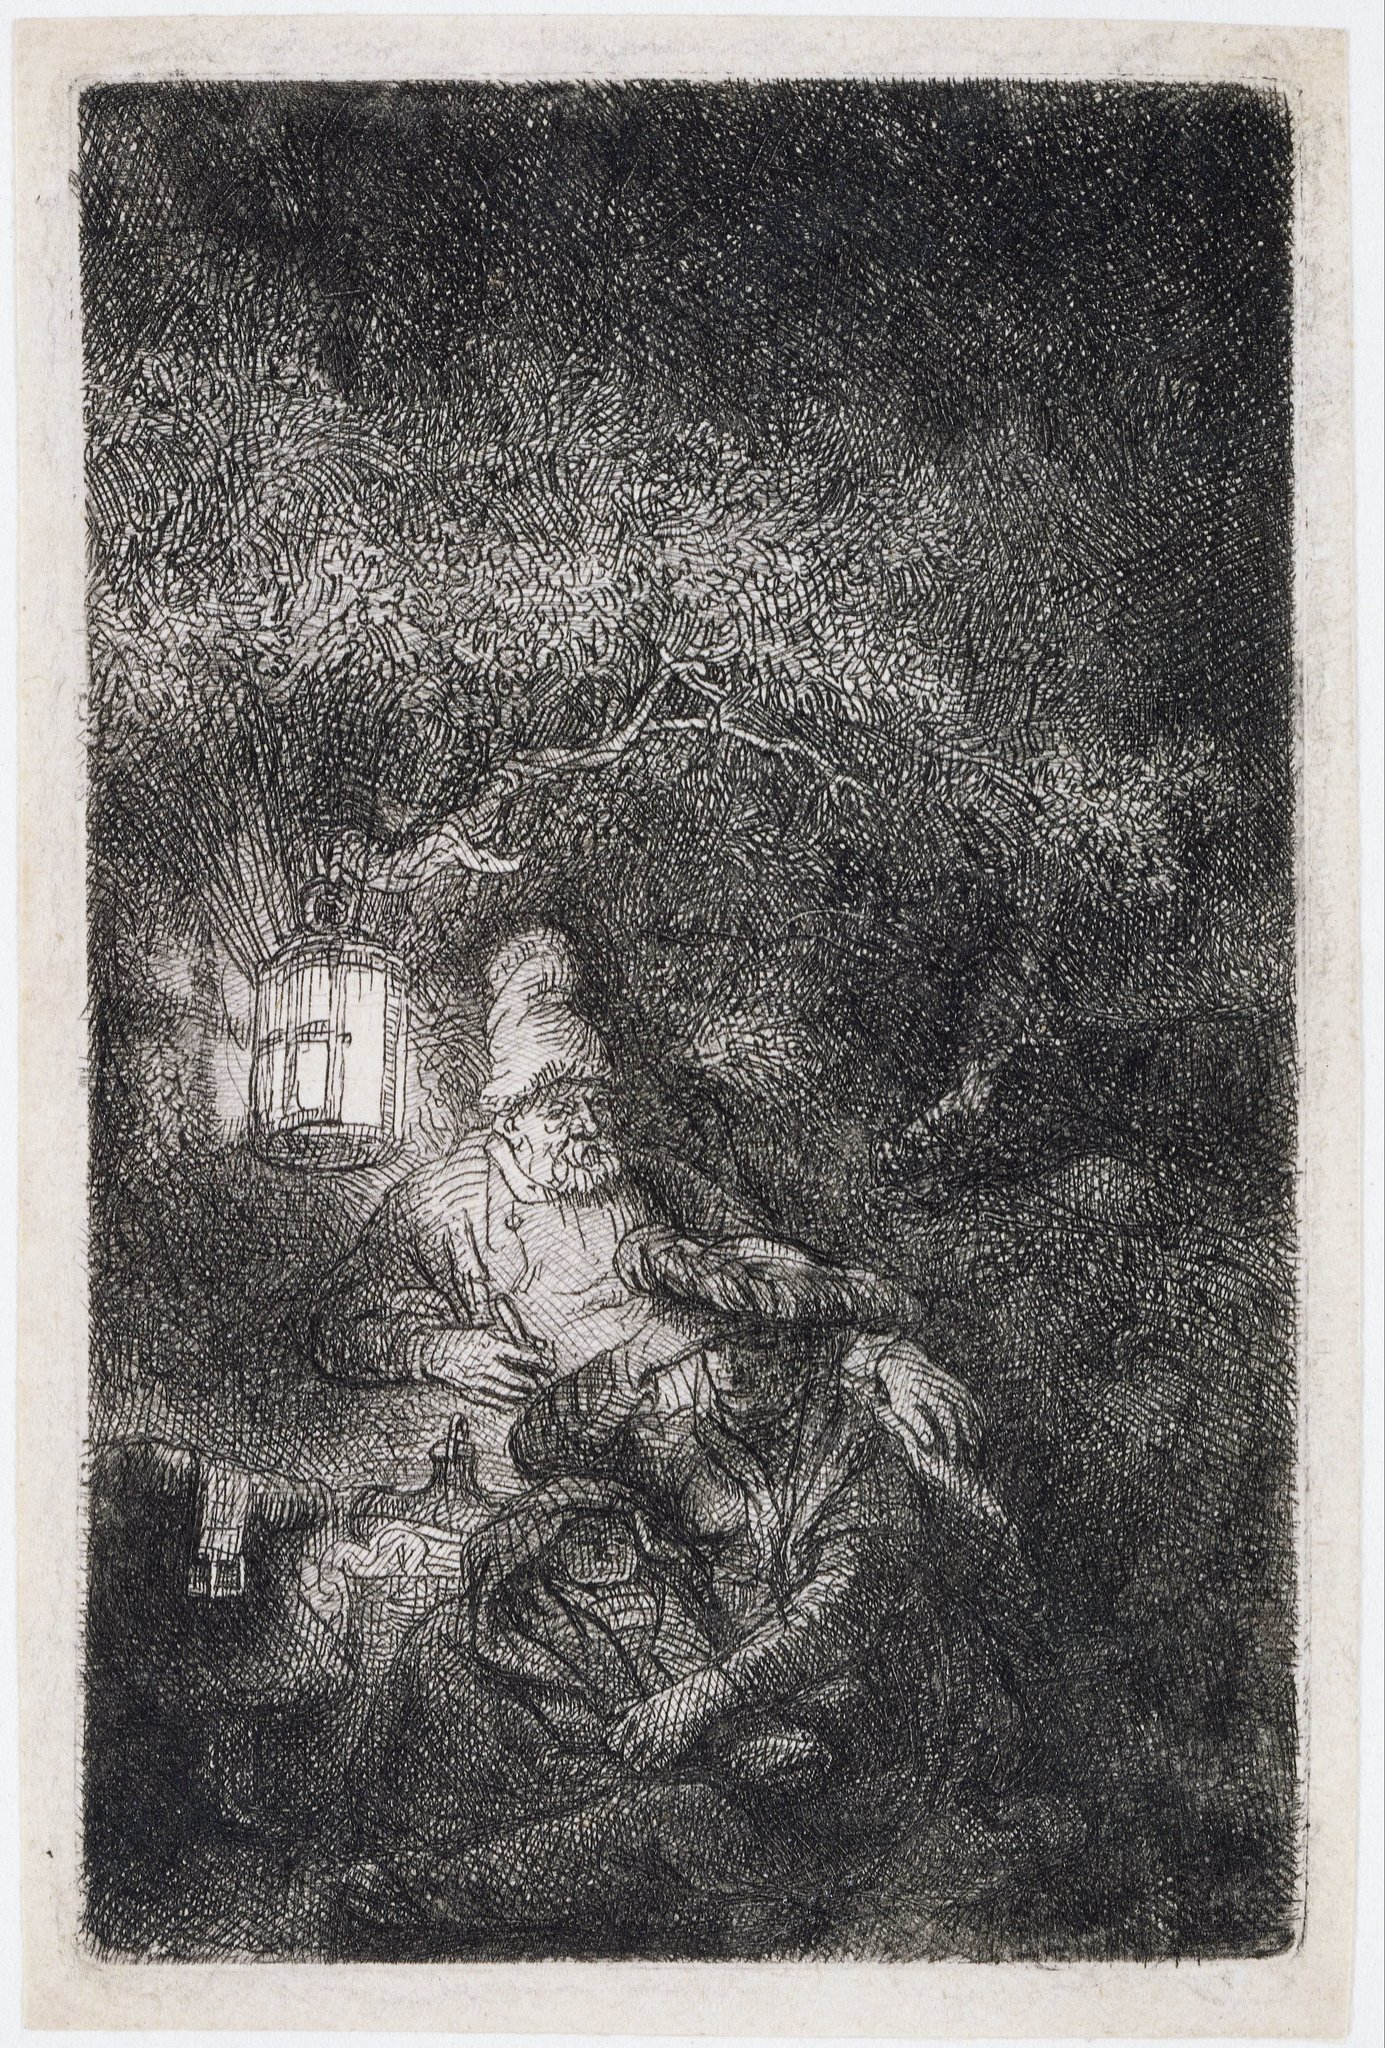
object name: print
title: The rest on the flight into Egypt: a night piece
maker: rembrandt van rijn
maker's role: draughtsman, painter, print maker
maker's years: 1606-1669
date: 1644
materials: paper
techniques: drypoint, etching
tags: rest on the flight into egypt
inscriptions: collector's mark: Lugt 240